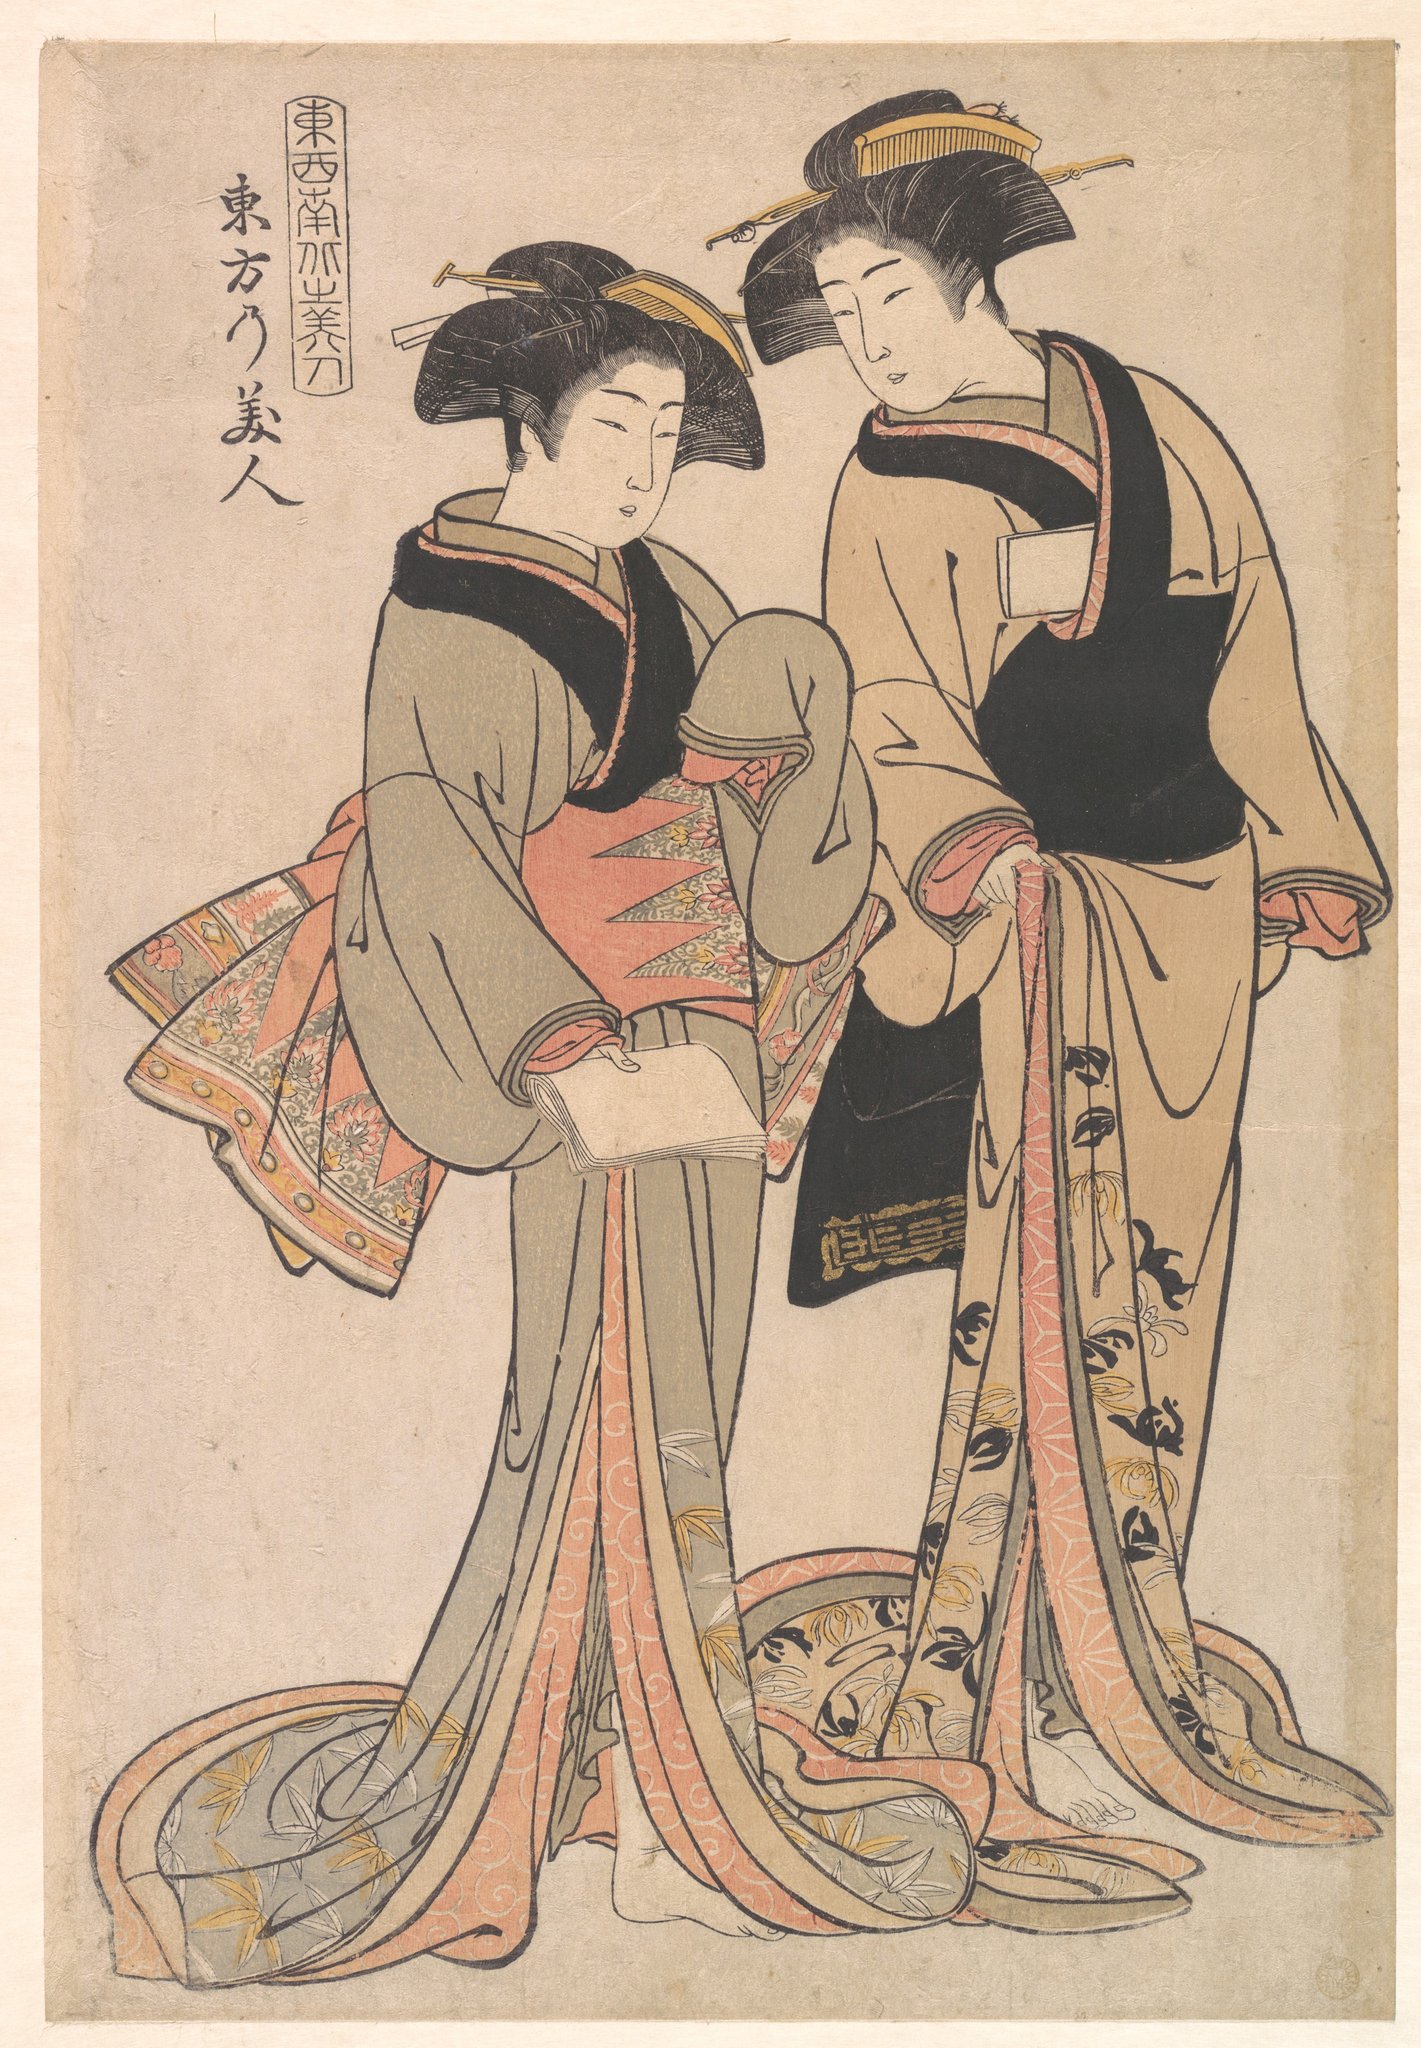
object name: print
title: Beauties of the East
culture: japanese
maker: kitao shigemasa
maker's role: artist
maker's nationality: japanese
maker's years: 1739-1820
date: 1782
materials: ink, paper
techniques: woodblock print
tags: women